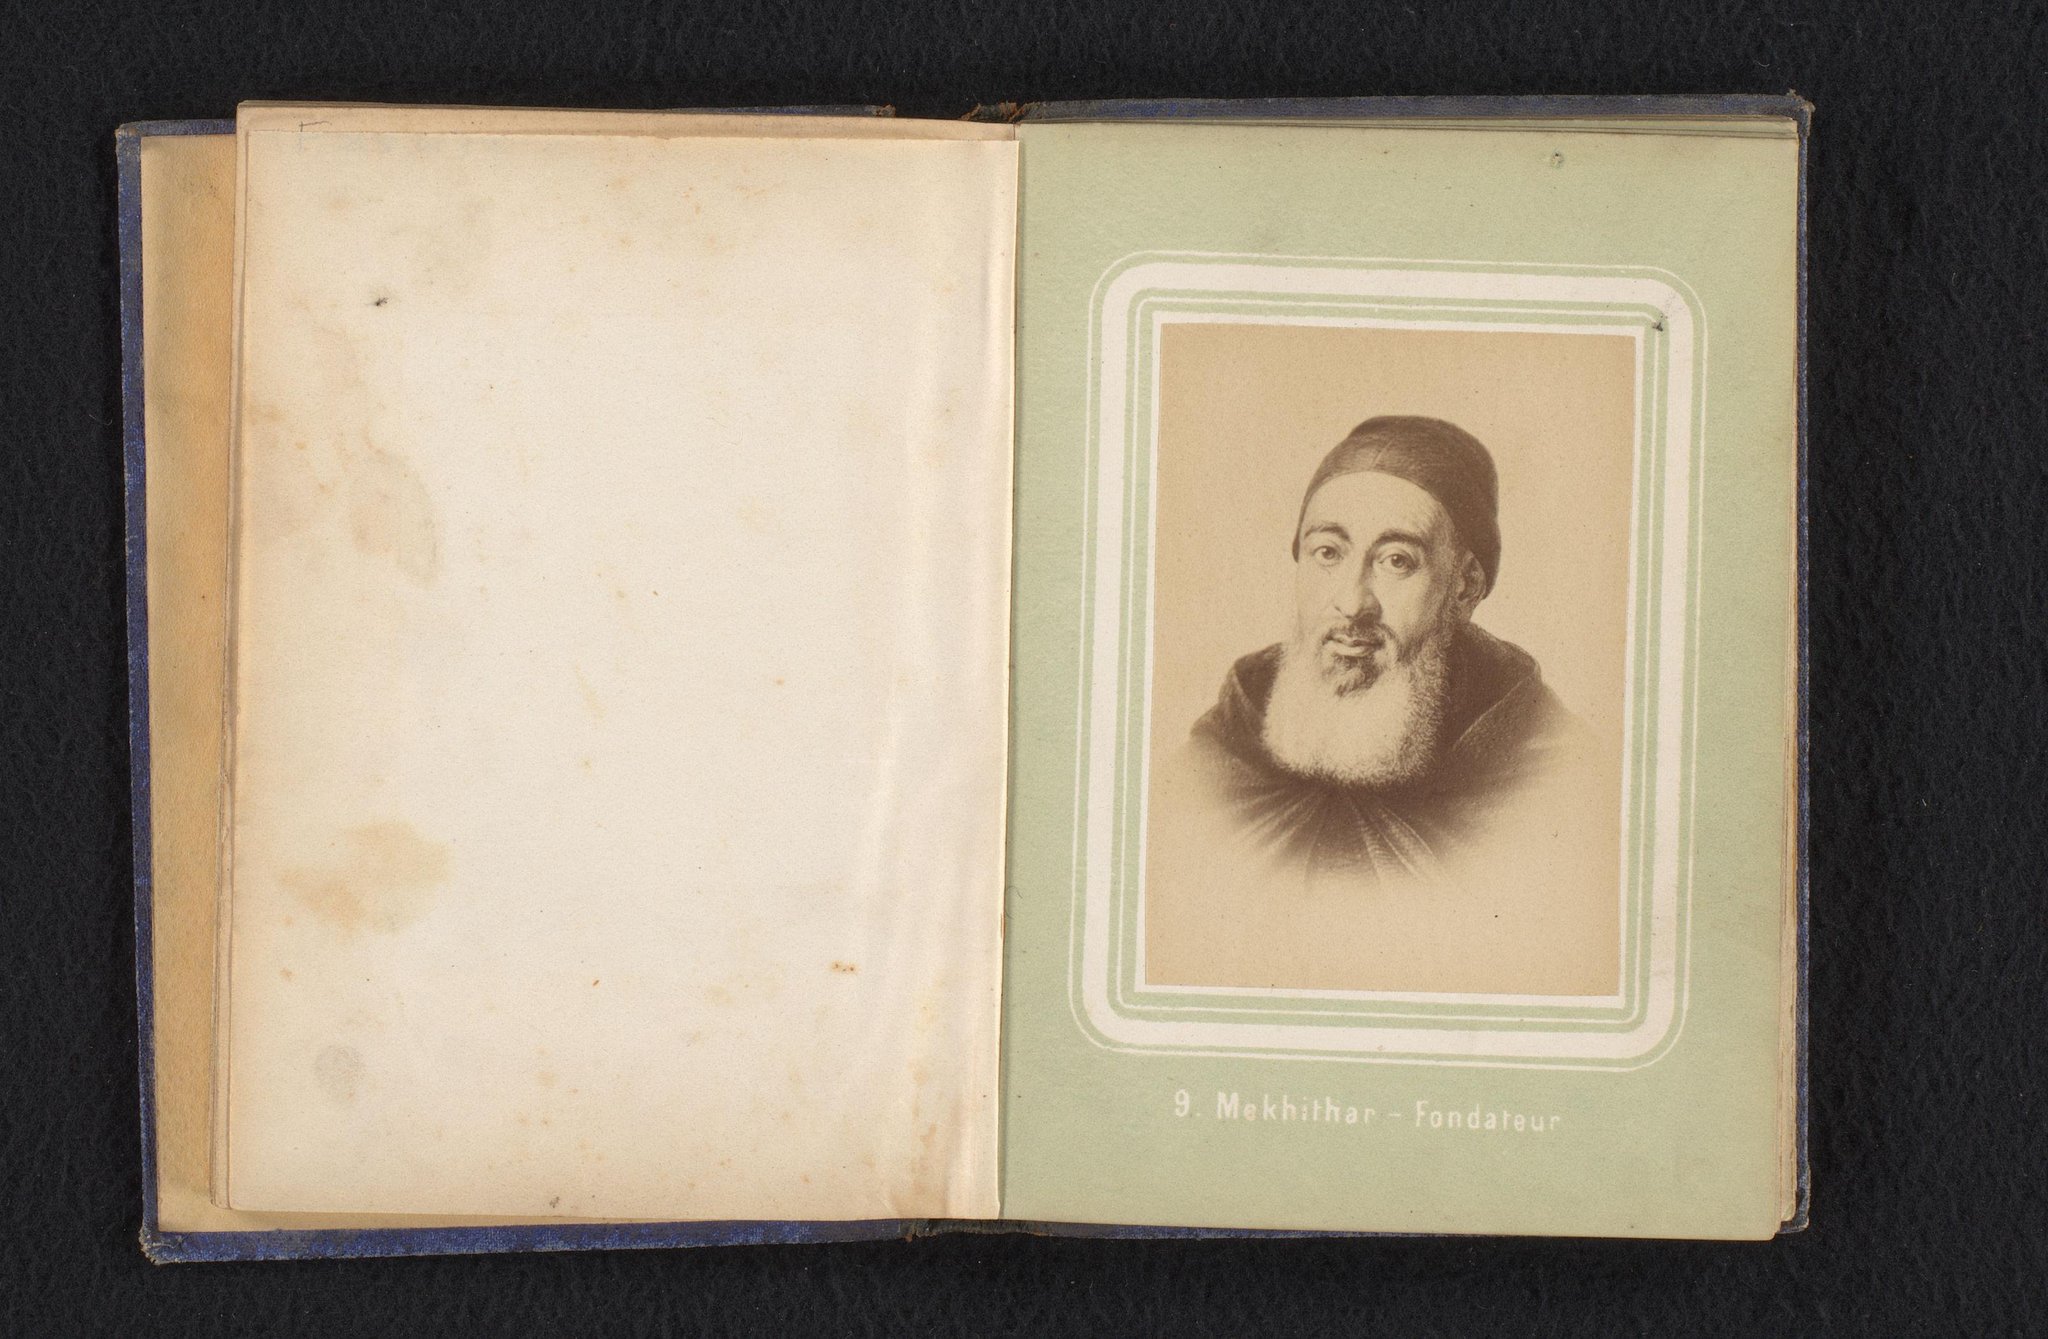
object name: page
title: Fotoreproductie van een getekend portret van Mkhitar Sebastatsi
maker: Anonymous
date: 1870-1890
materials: paper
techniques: albumen print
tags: adult man, historical persons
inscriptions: number: ‘9.’